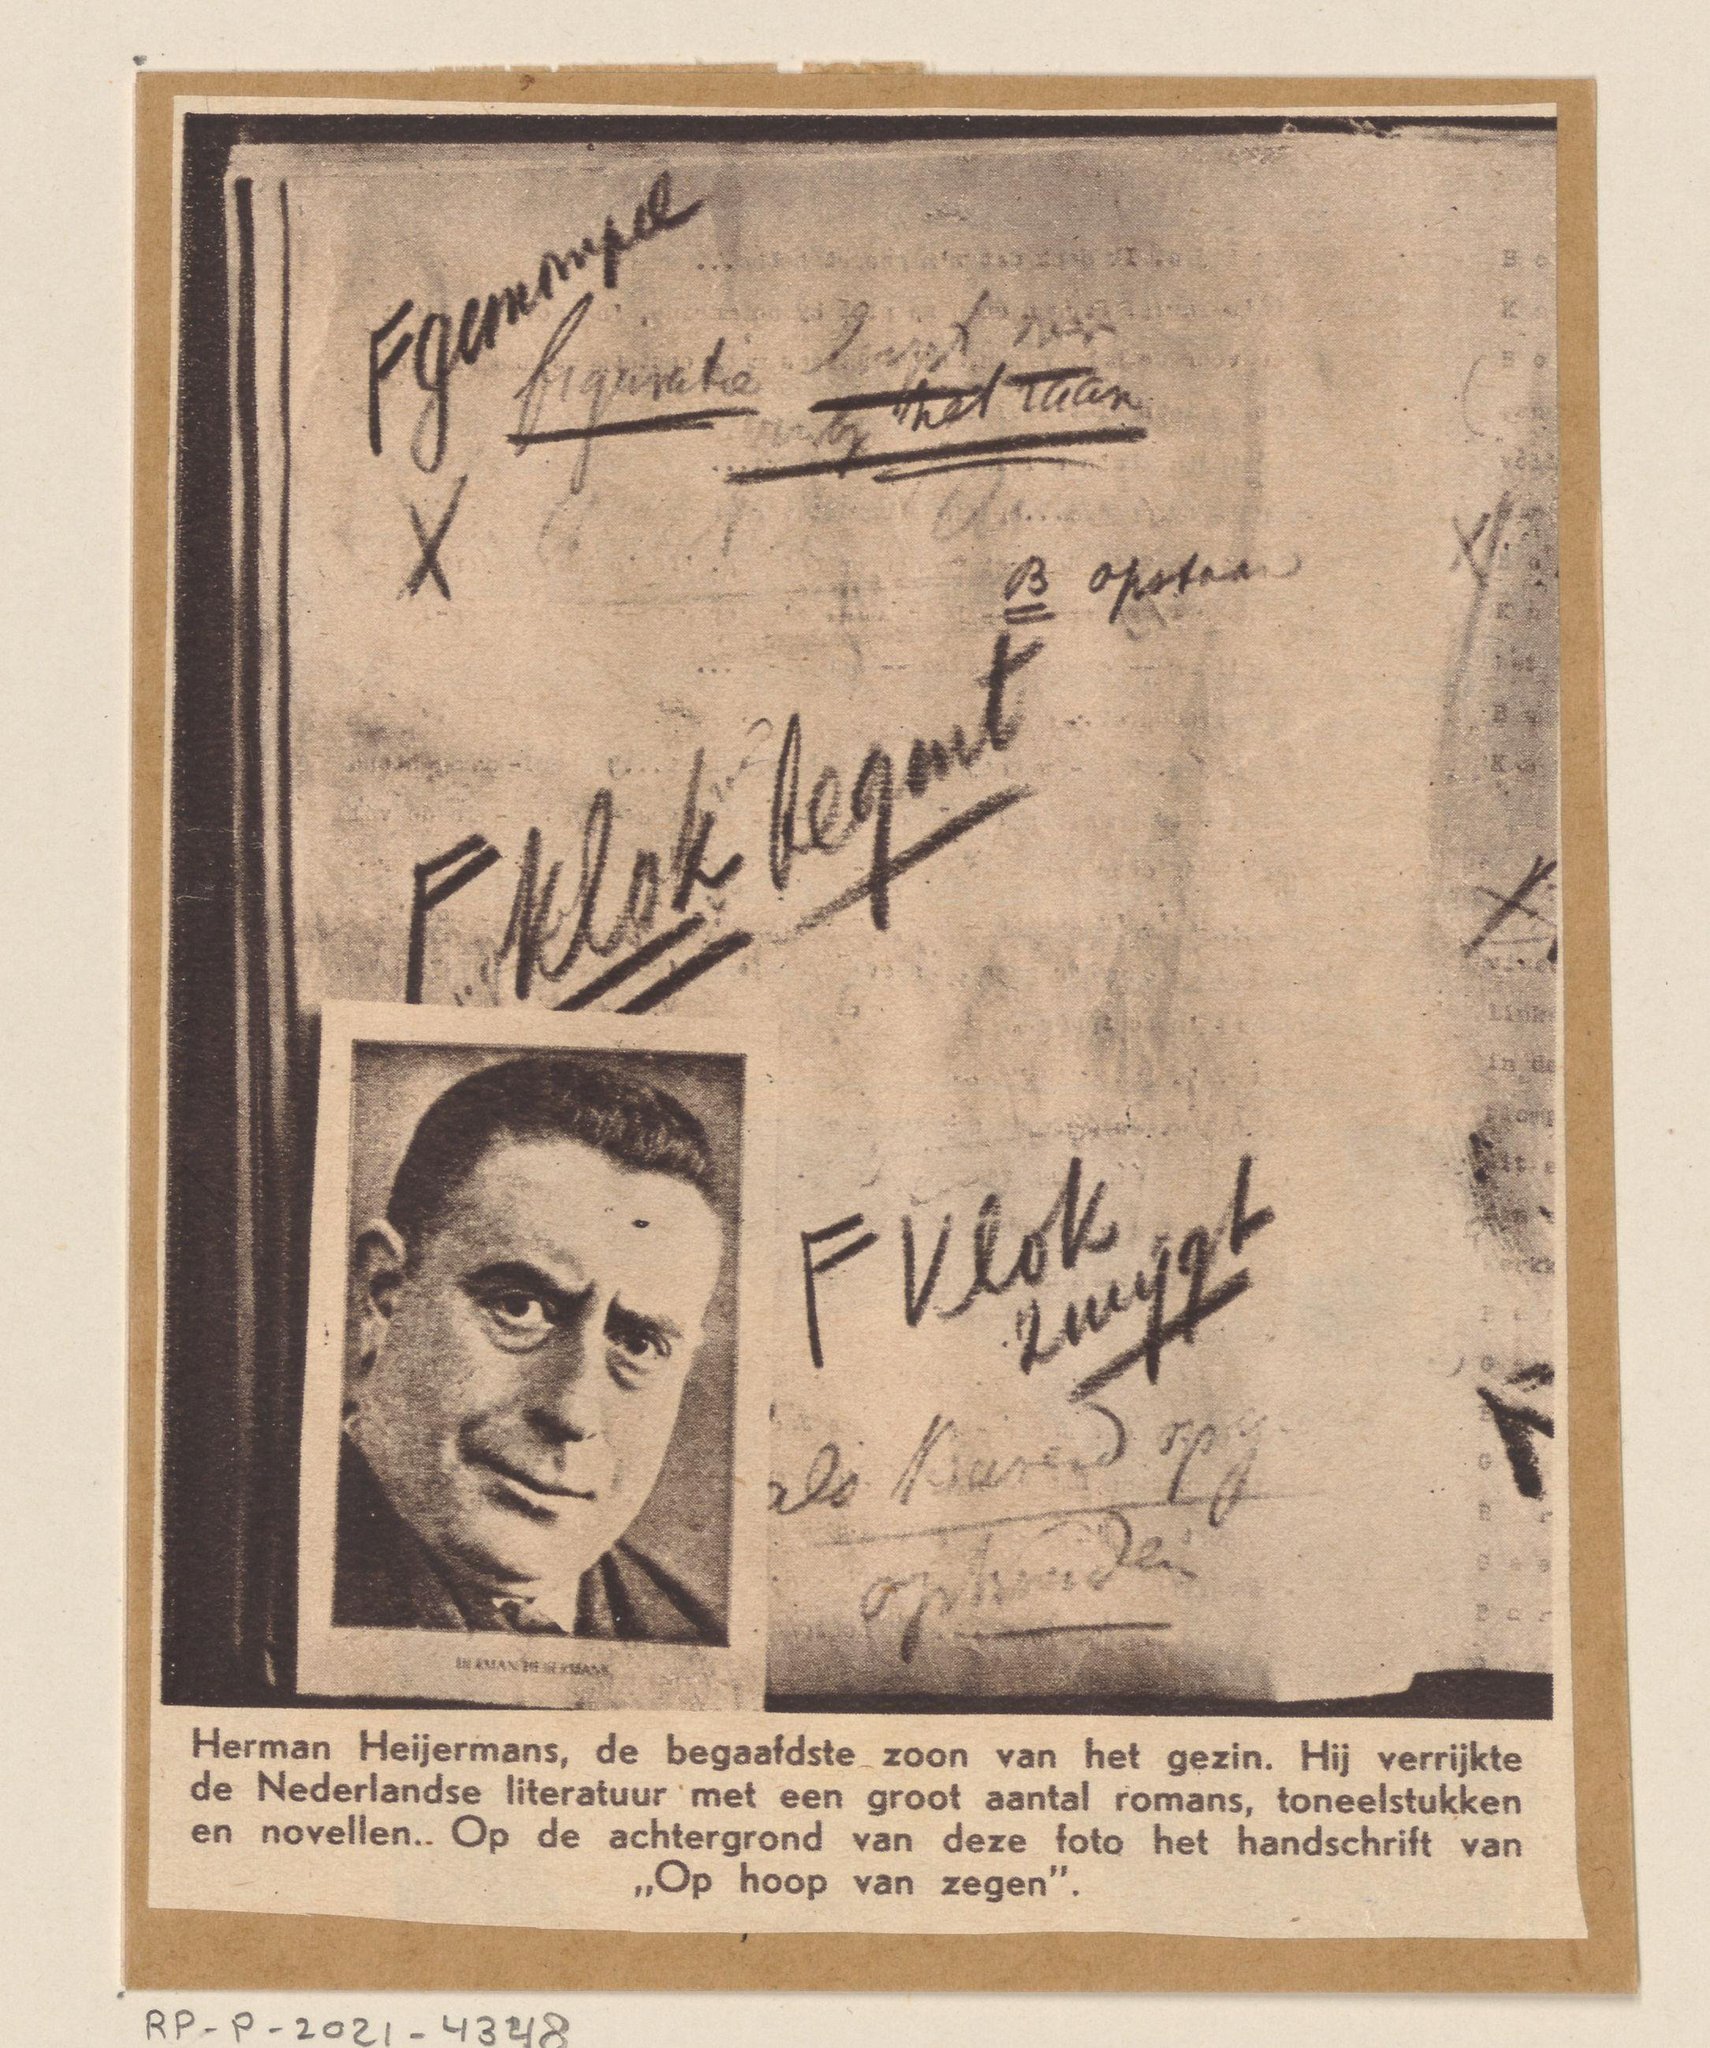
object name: photomechanical print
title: Werk en portret van Herman Heijermans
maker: Anonymous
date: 1937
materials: paper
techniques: rotogravure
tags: rotterdam, herman heijermans, historical persons, portrait of a writer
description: Prent uit: Wij, ons werk, ons leven 3 (1937), nr. 35, 1 oktober 1937.